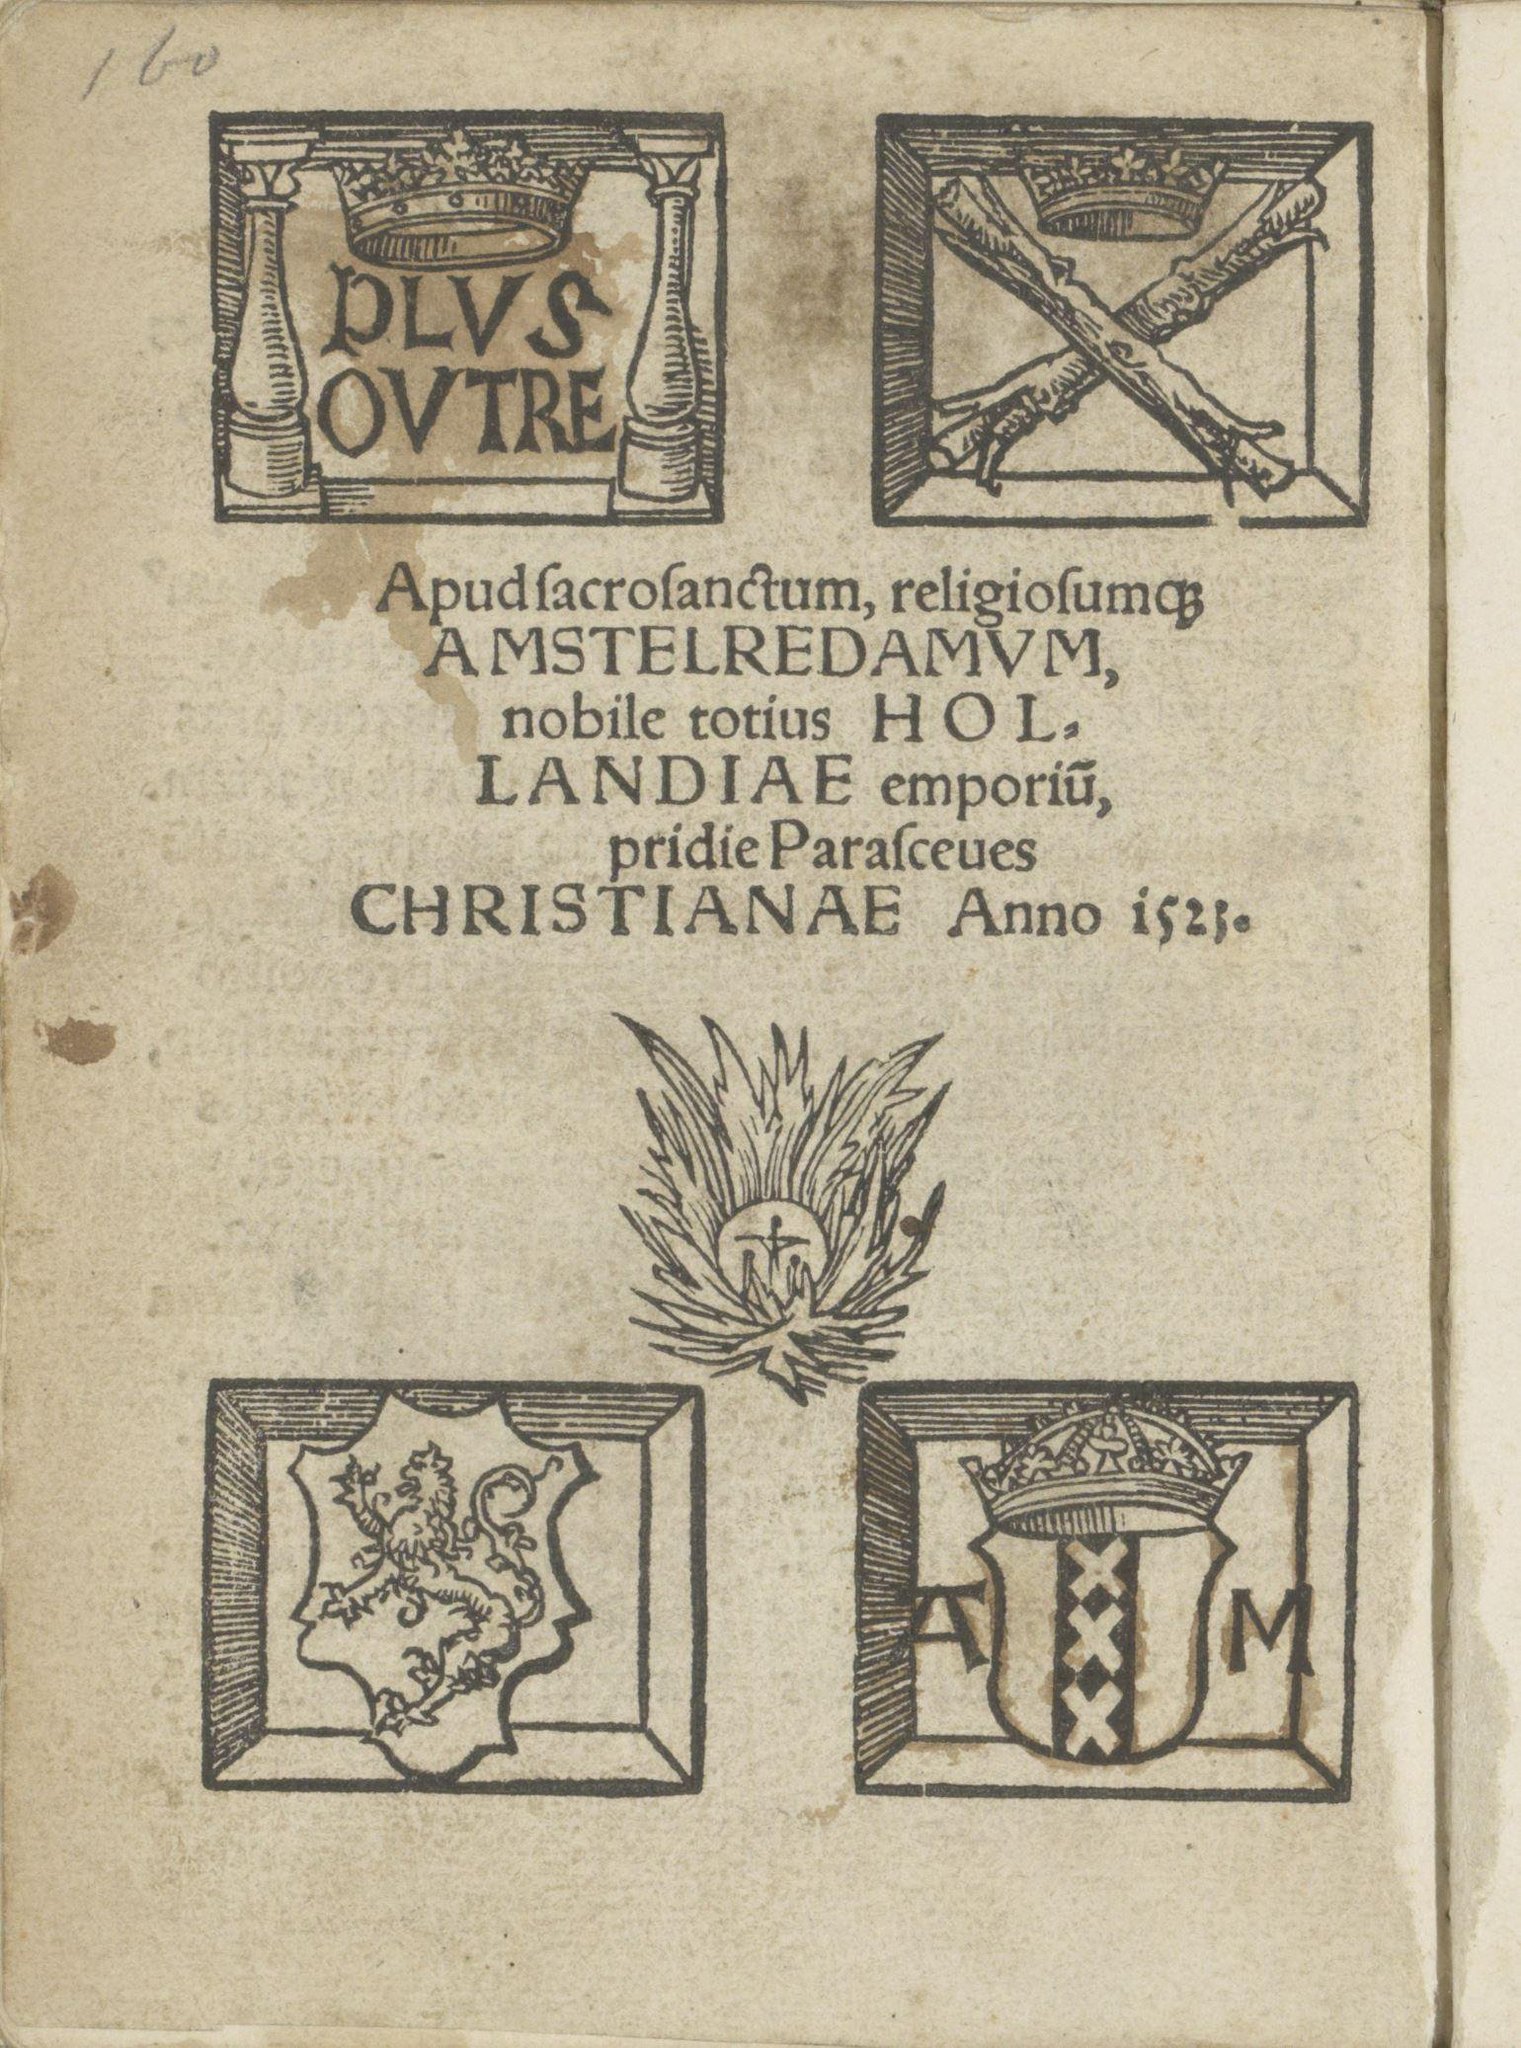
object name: book illustration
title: Wapenschilden van Amsterdam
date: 1523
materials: paper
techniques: woodcut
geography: amsterdam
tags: coat of arms (as symbol of the state, etc.) (+ city; municipal), amsterdam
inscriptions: date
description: Linksboven het devies Plus Ultra van keizer Karel V. Rechtsboven een andreaskruis met daarboven de keizerskroon, beiden onderdelen van het wapen van Amsterdam. Linksonder de Hollandse leeuw. Rechtsonder het schild met drie andreaskruizen en de keizerskroon. In het midden een hostie in het vuur, verbeelding van het mirakel van Amsterdam. Prent maakt deel uit van een boek.